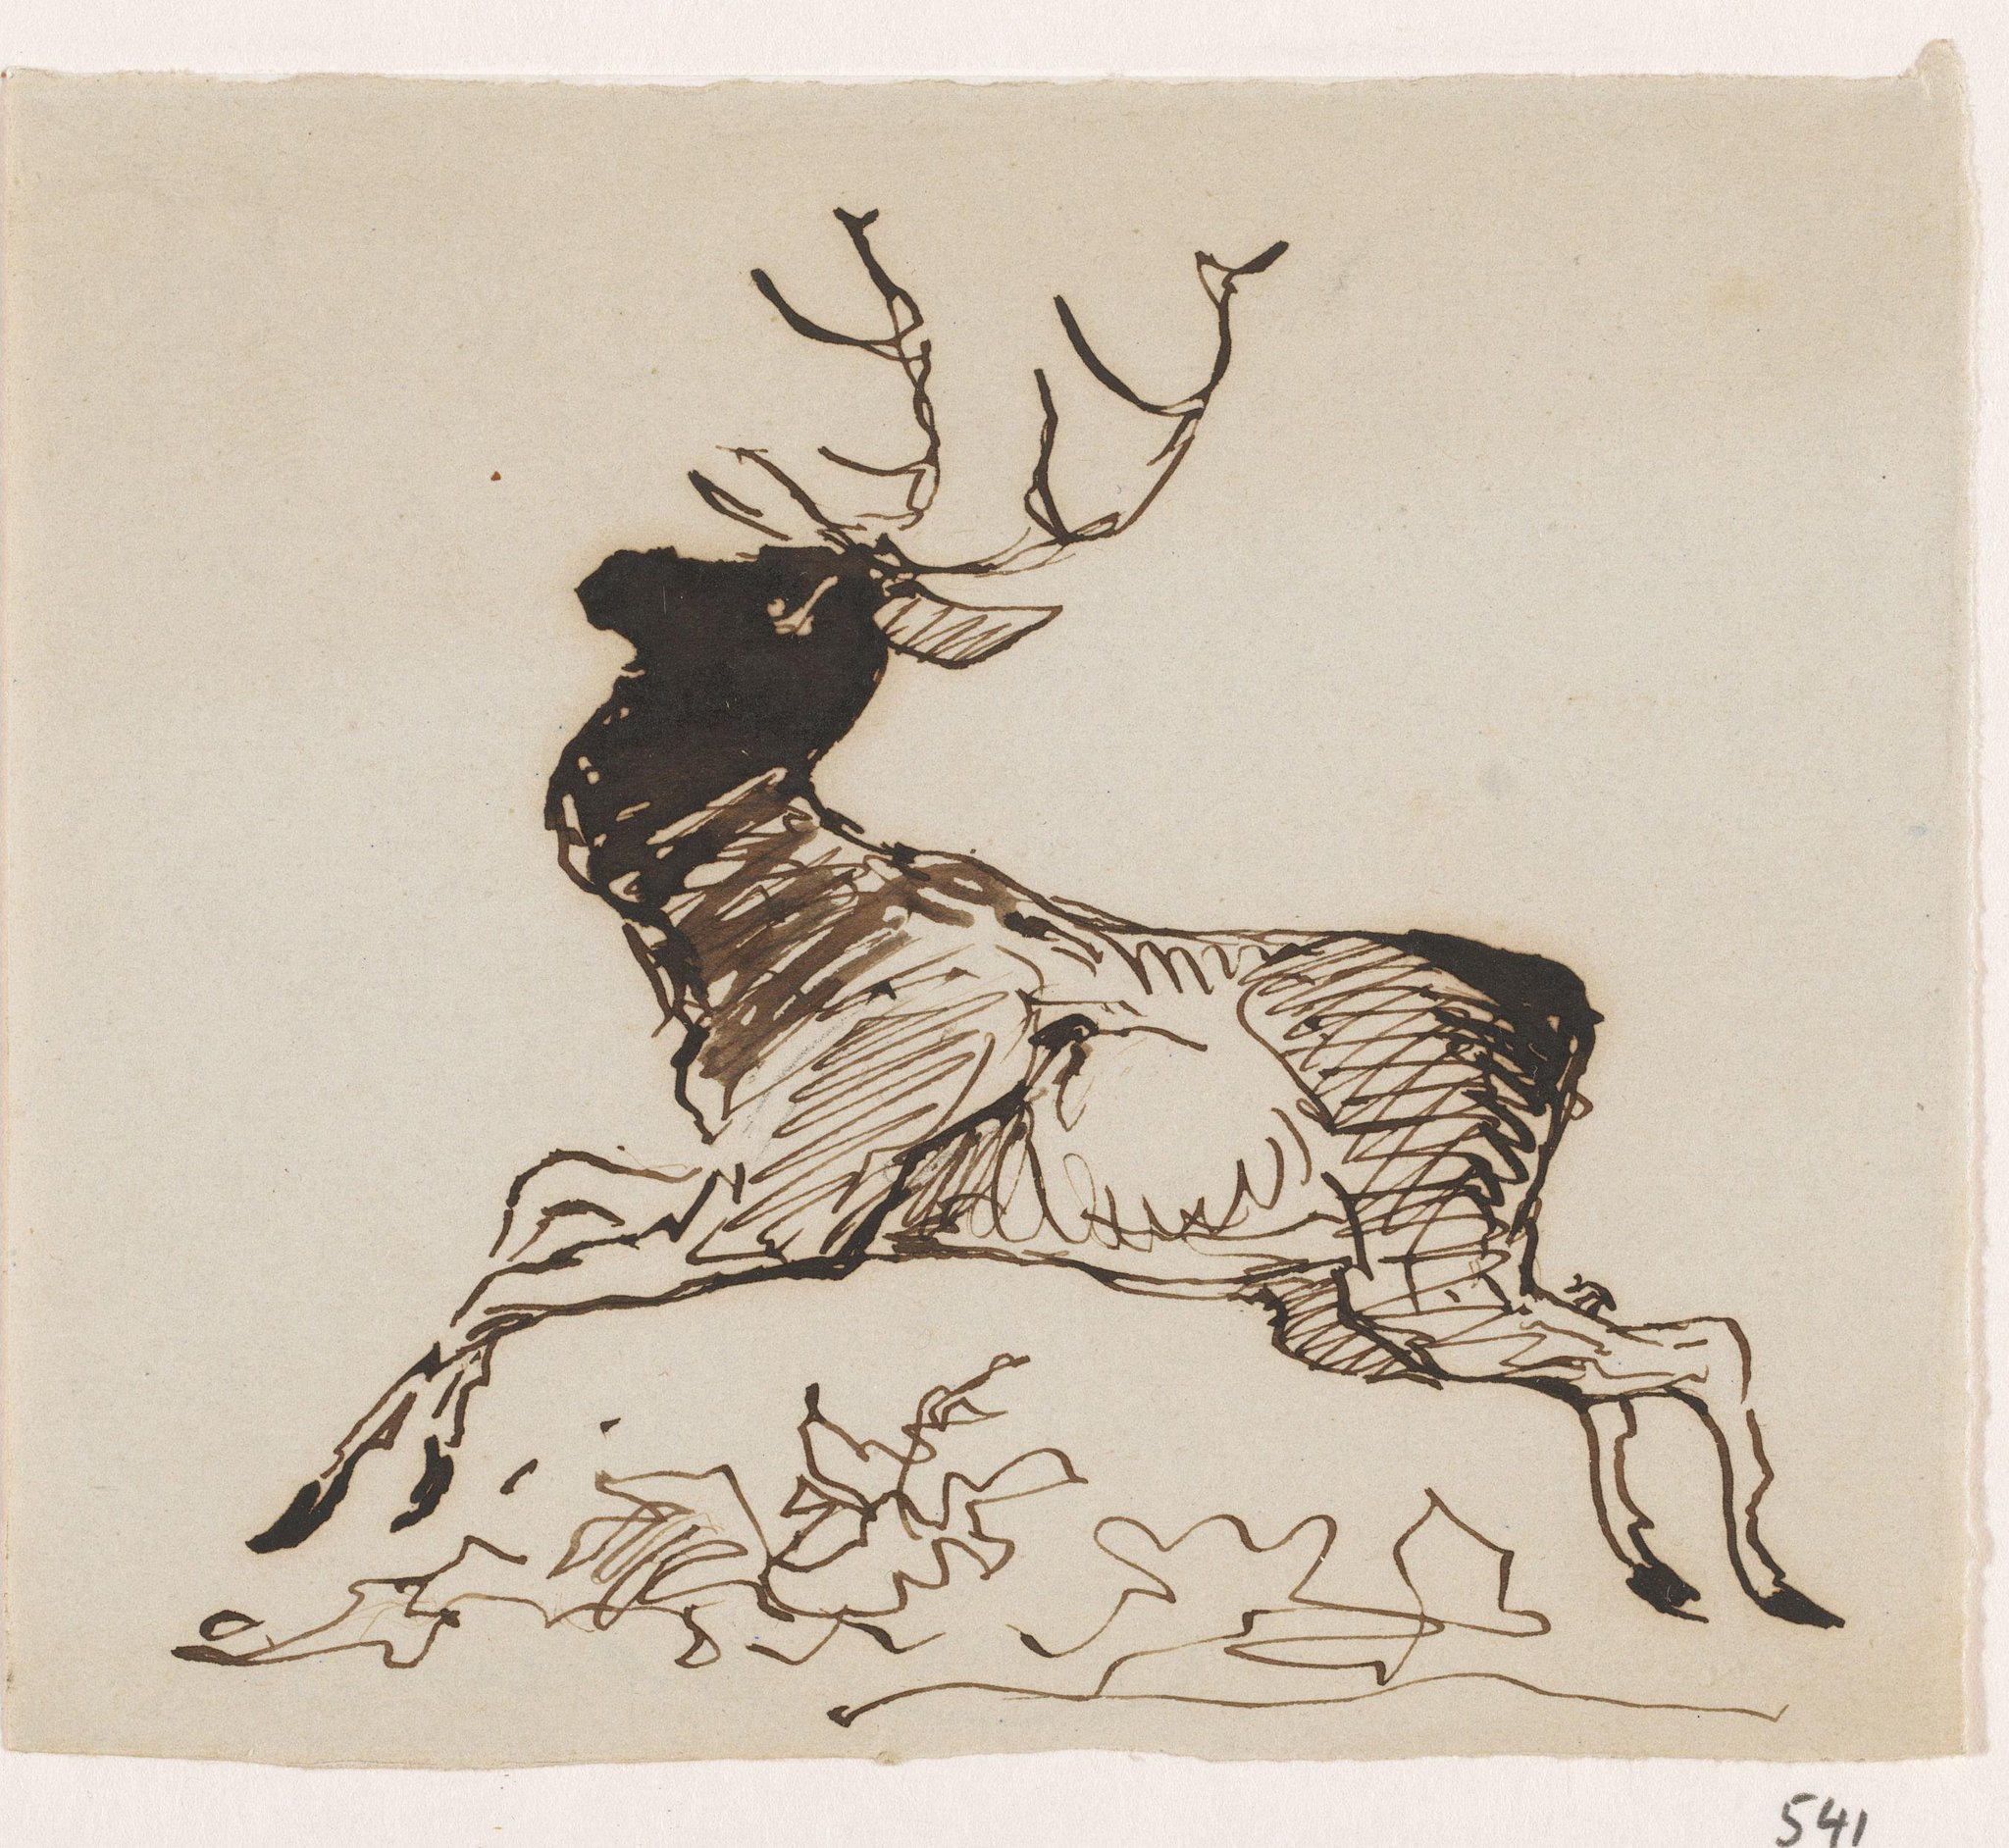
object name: drawing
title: Hert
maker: johannes tavenraat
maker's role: draughtsman, painter, print maker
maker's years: 1809-1881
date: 1840-1880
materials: ink, paper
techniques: pen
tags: hoofed animals: deer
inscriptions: collector's mark: Lugt 2228